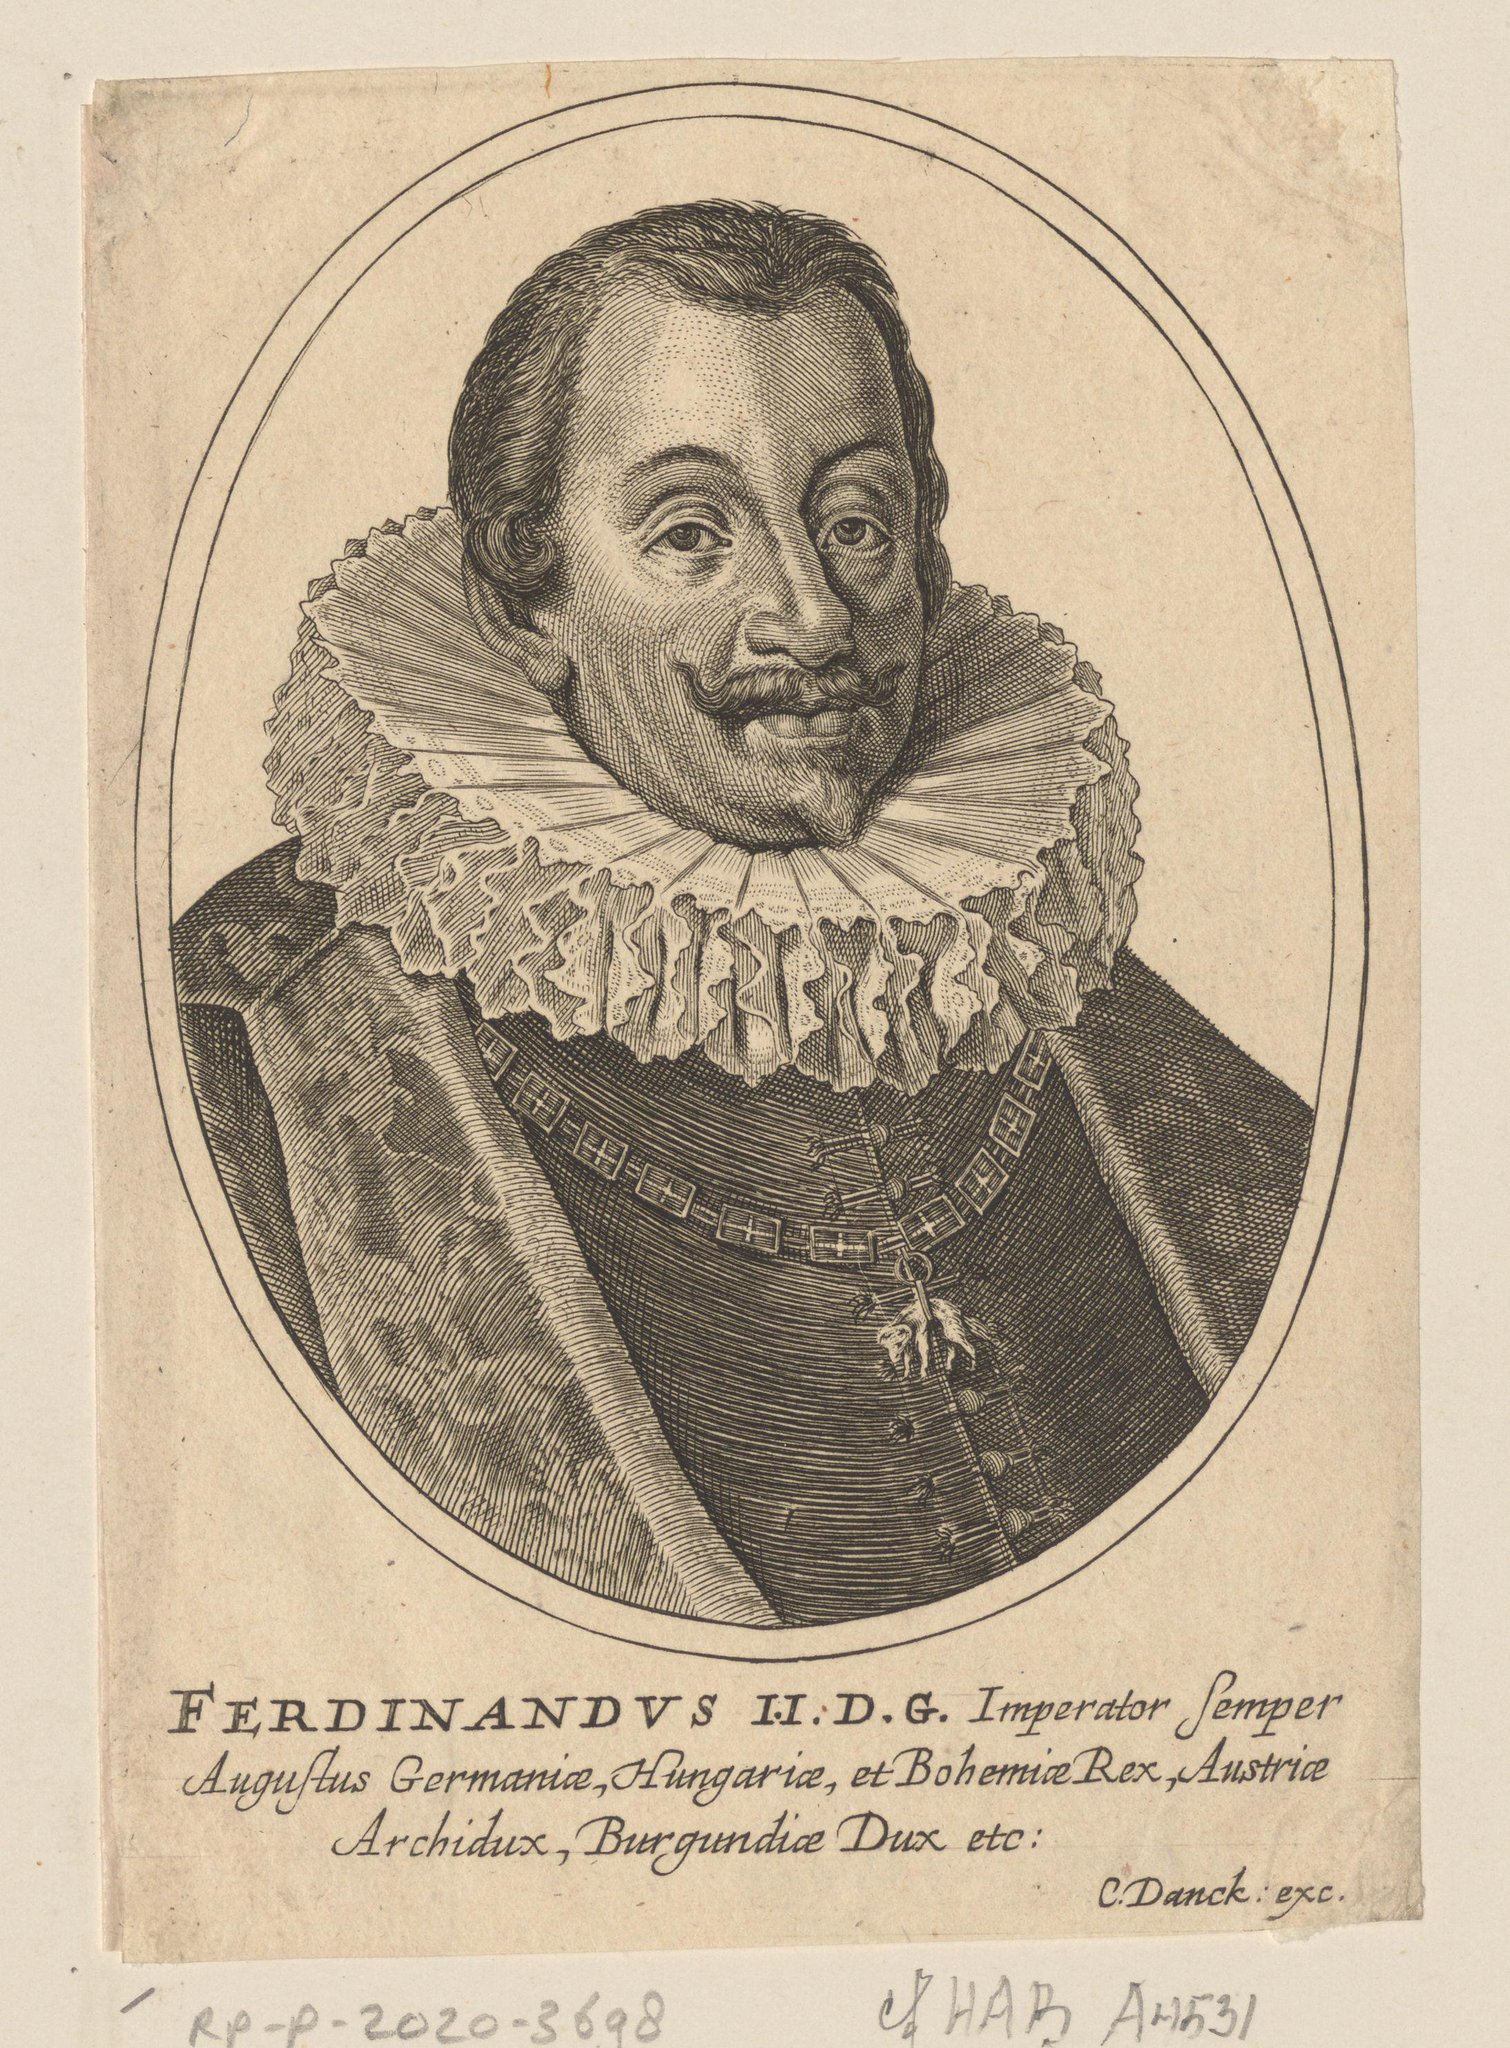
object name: print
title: Portret van keizer Ferdinand II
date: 1642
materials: paper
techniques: engraving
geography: amsterdam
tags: vienna, ferdinand ii (duits keizer), historical persons, knighthood order of the golden fleece, emperor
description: Prent met tekst op verso gebruikt in: Historis oft waerachtich verhael van den gantschen toestant van oorlooge, soo die ghevoert is in Duytschlandt (...). Amsterdam: Cornelis Danckerts, 1642, p. 4.